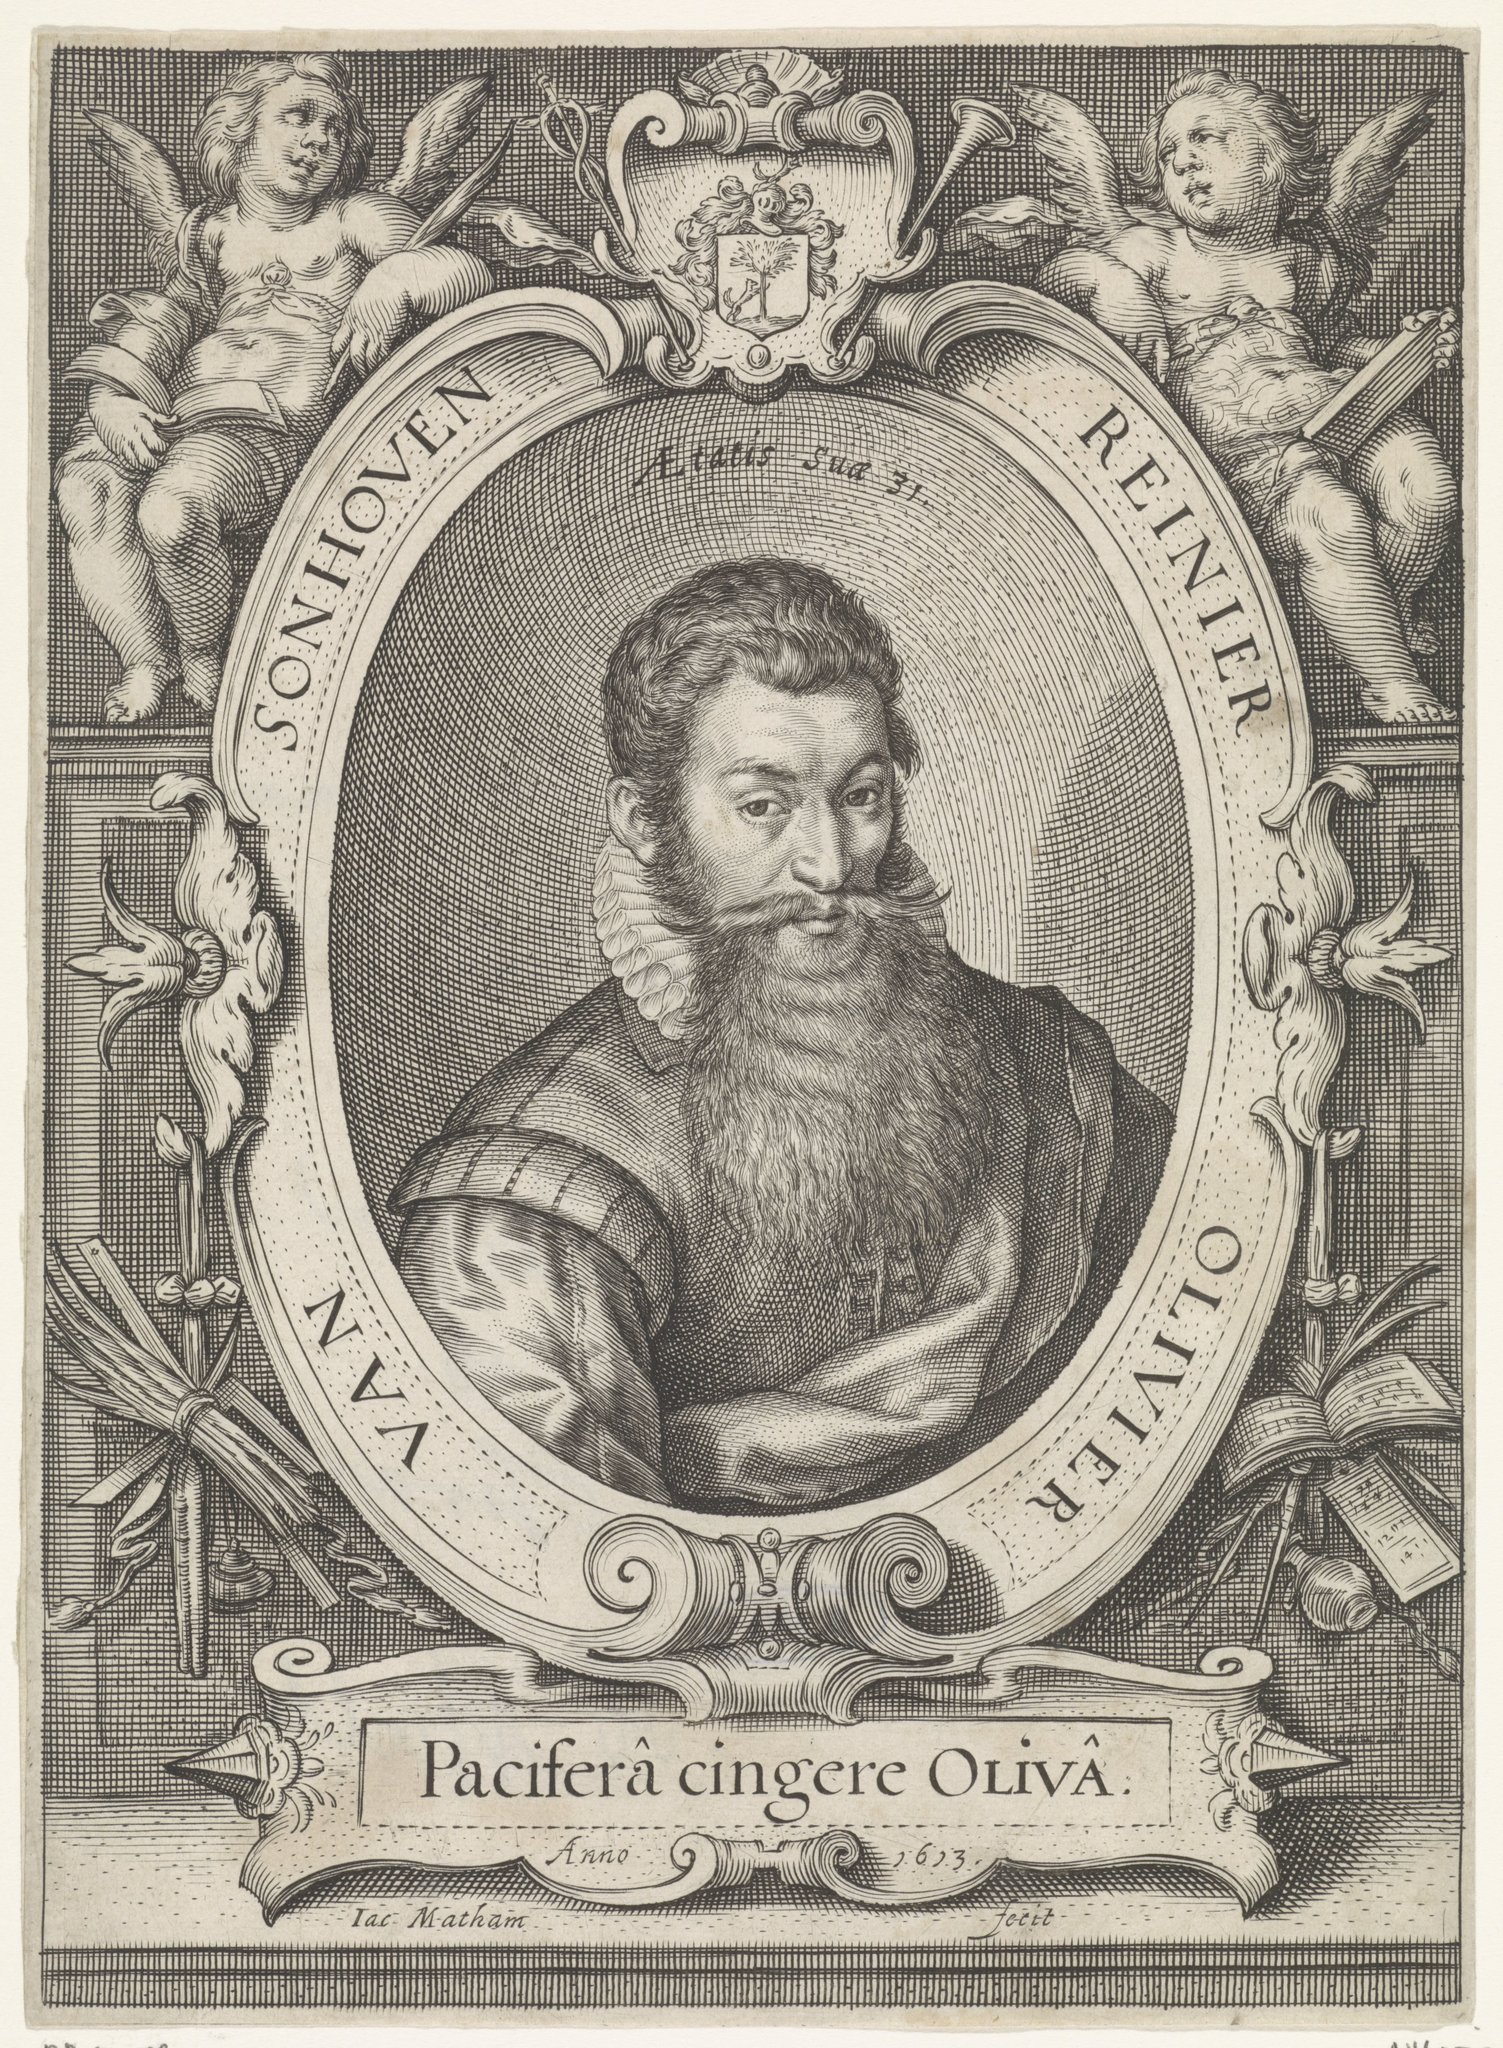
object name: print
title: Portret van Reinier Olivier van Zonhoven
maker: jacob matham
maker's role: draughtsman, print maker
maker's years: 1571-1631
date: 1613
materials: paper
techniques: engraving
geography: haarlem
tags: historical persons, scholastic education, tuition (+ teacher, professor)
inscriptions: collector's mark: Lugt 2228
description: Portret van de letterkundige Reinier Olivier van Zonhoven. Bovenaan de ovale omlijsting zijn wapen tussen twee putti, onderaan schrijfattributen.